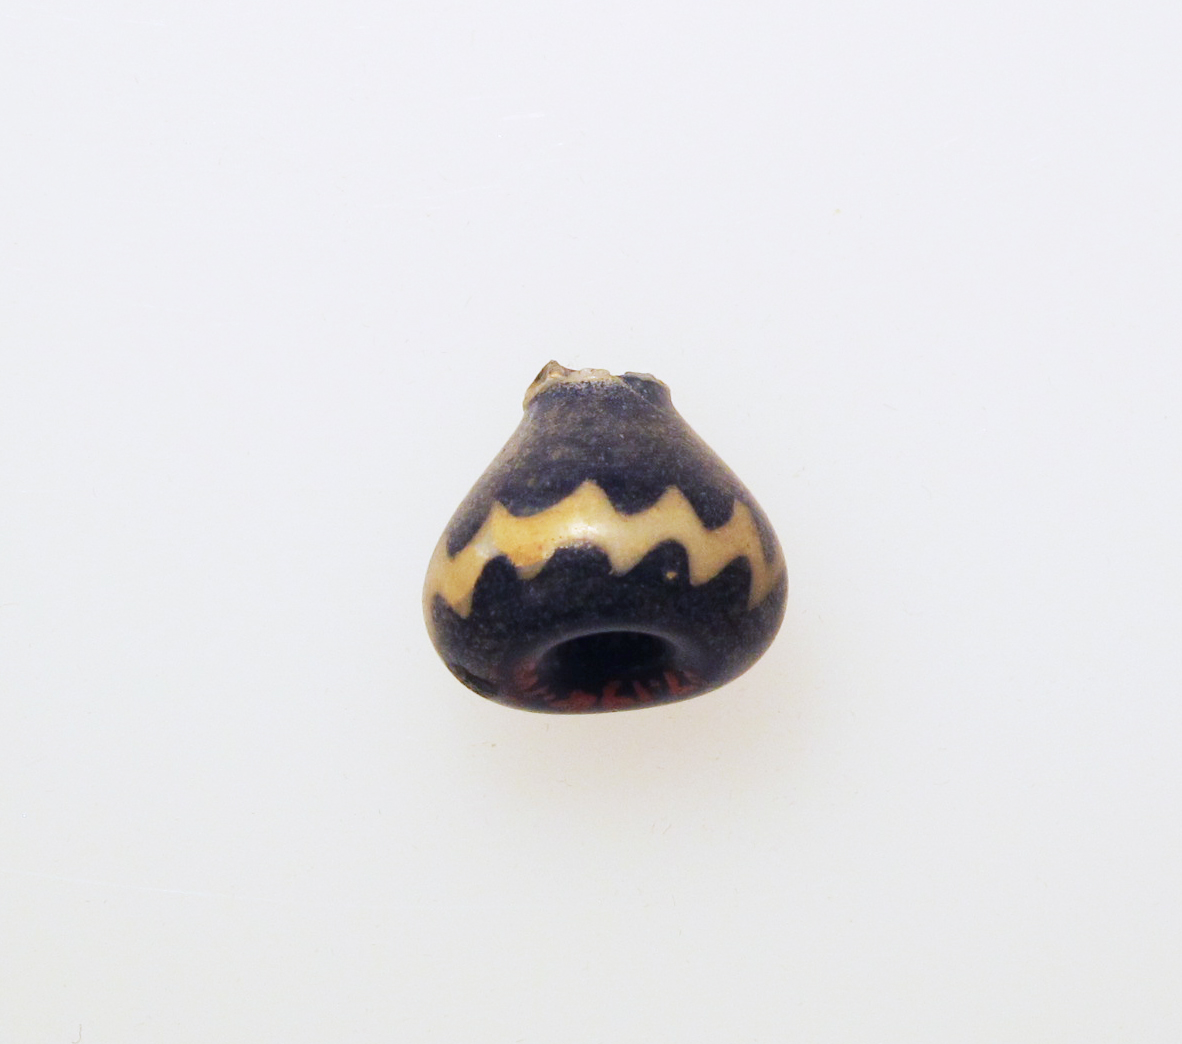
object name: bead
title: Glass bead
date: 7000 BCE-330 CE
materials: glass